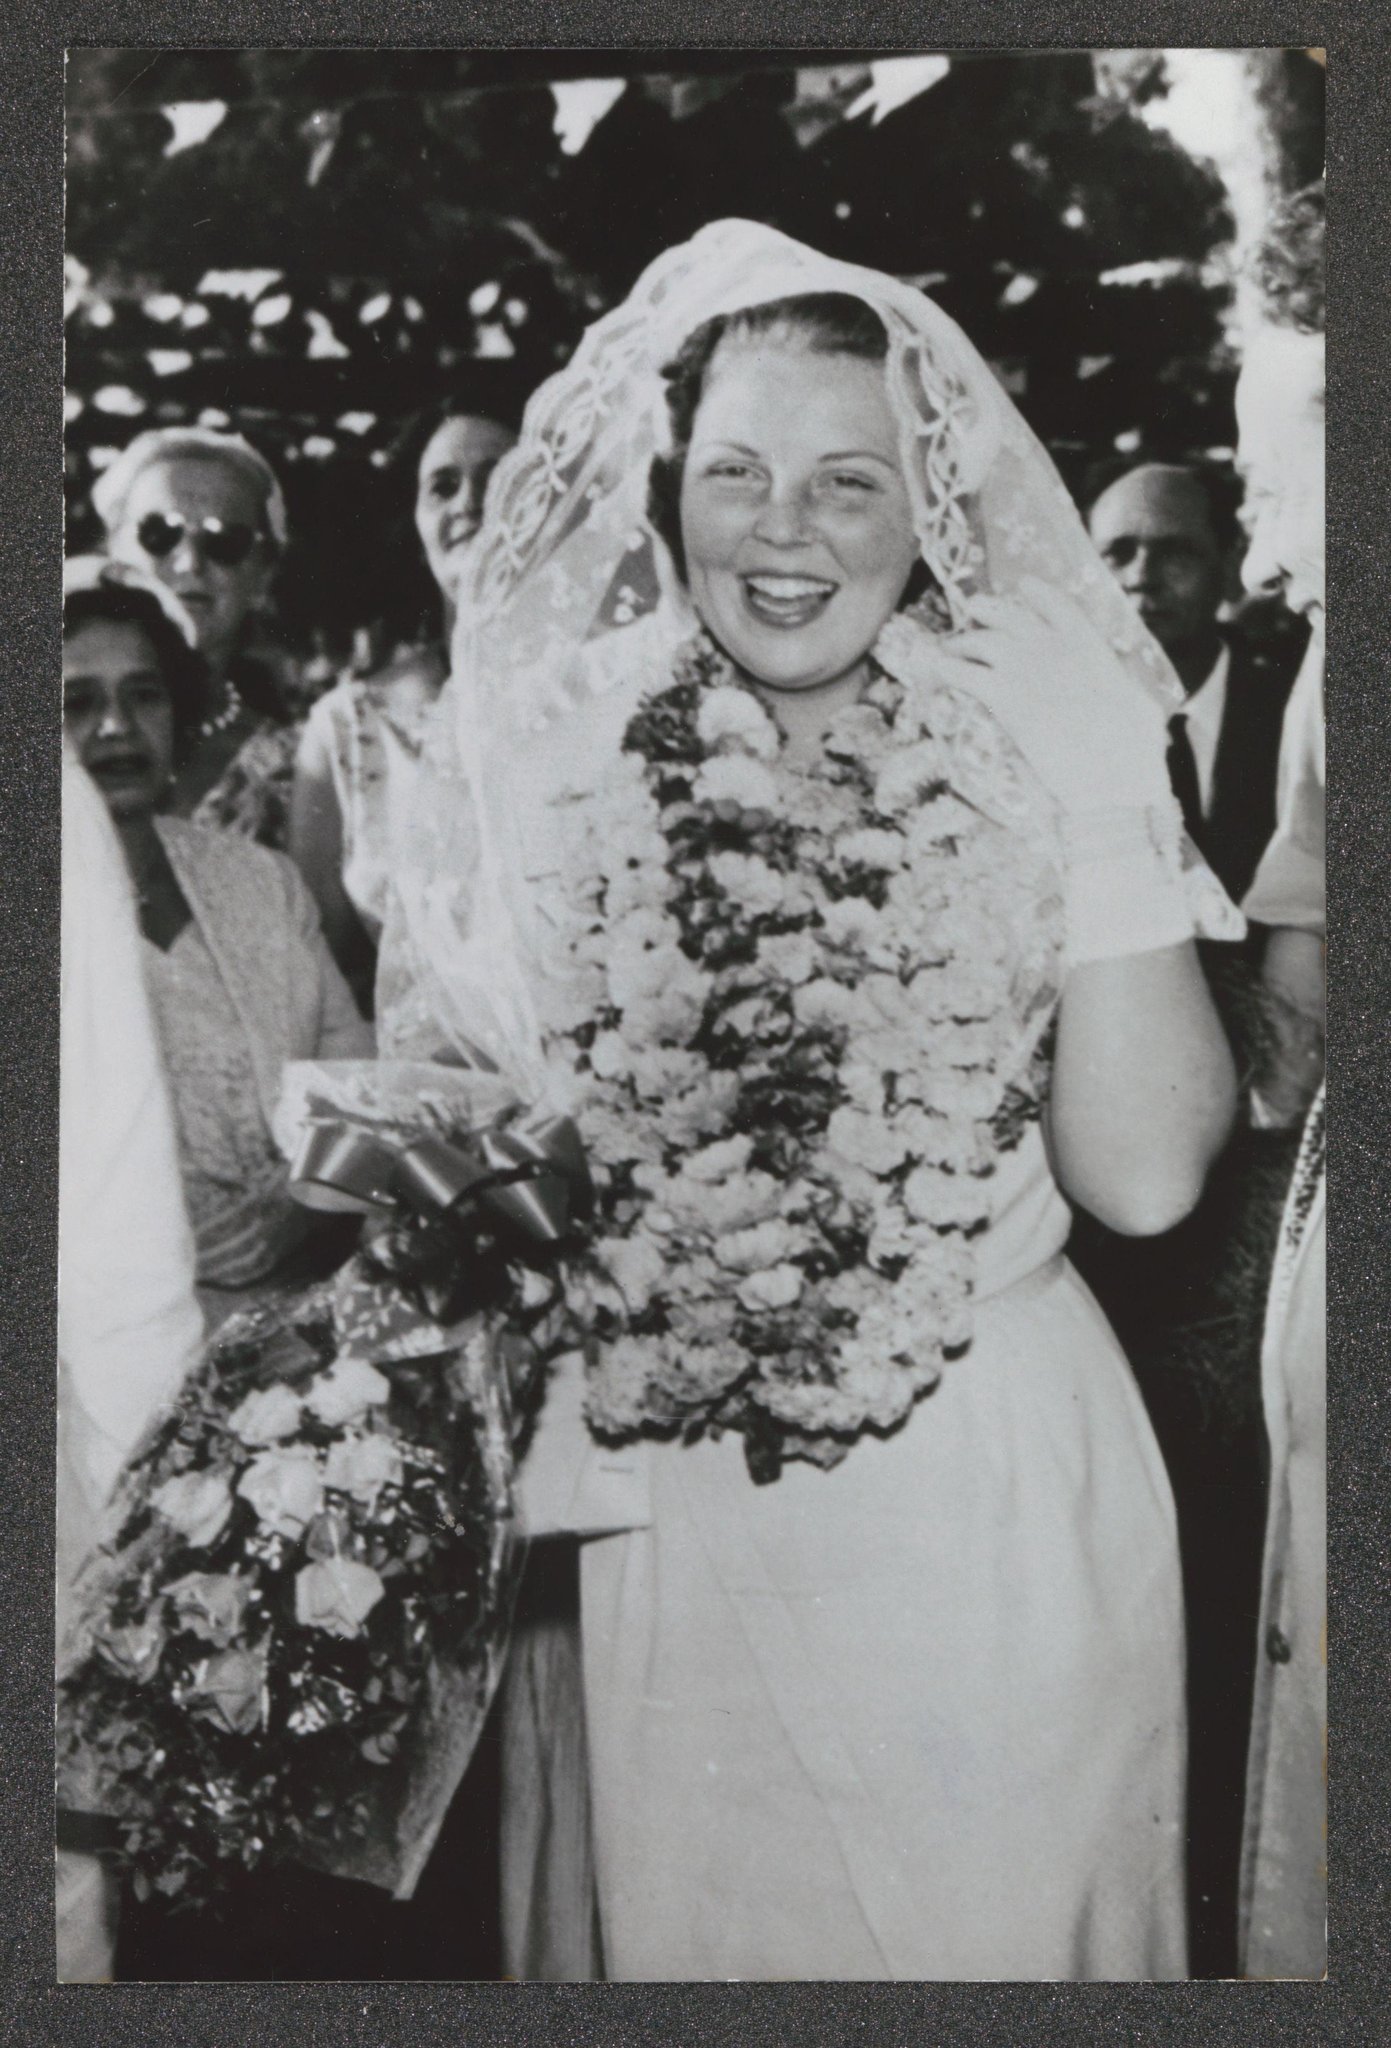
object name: photograph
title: Prinses Beatrix tijdens een bezoek aan Suriname, uitgedost als Hindostaanse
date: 1958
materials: paper, photographic support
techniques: gelatin silver print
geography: netherlands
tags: beatrix (koningin der nederlanden), suriname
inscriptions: annotation: ‘Bezoek van Prinses Beatrix aan Suriname. / foto:Toen Prinses Beatrix de Hindostanen bezocht, stonden / deze erop om Prinses Beatrix als Hindostaanse te kle- / den.Prinses Beatrix als Hindostaanse. / FO T O-A N E F O 2 maart 1958’